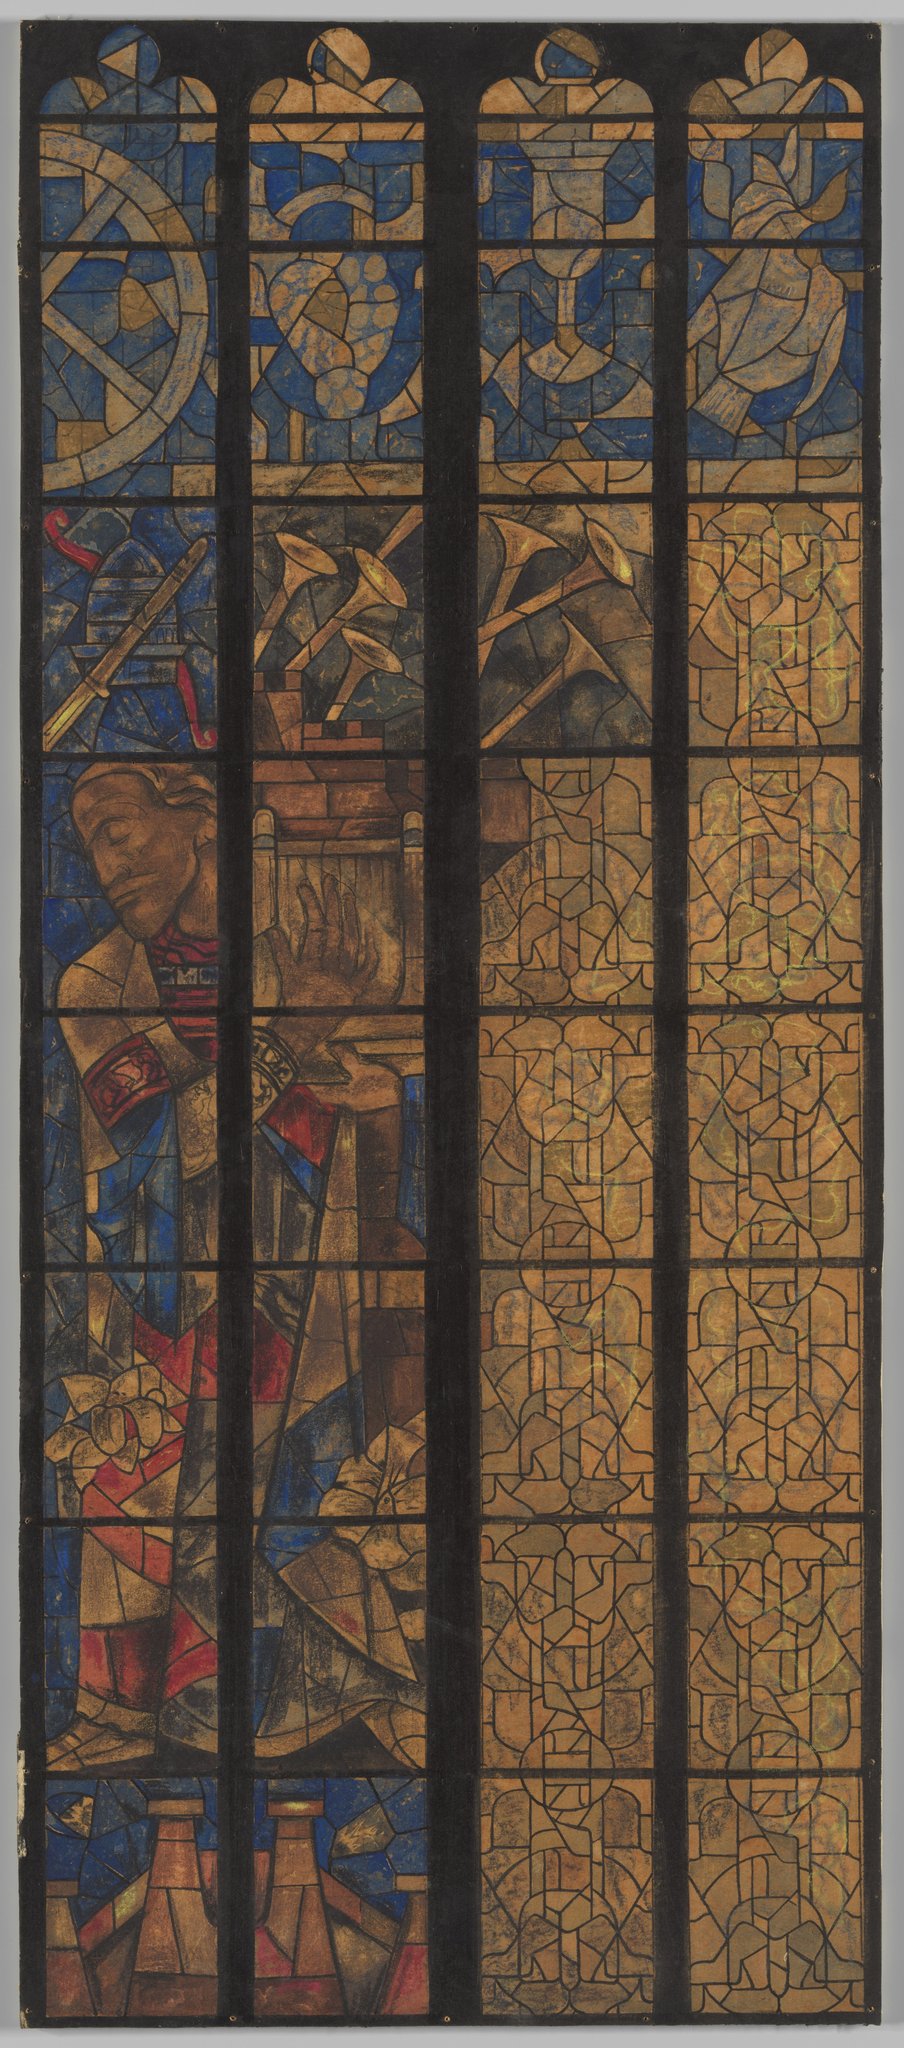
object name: drawing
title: Ontwerp voor een raam in het Noordertransept in de Dom te Utrecht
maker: richard nicolaüs roland holst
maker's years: 1868-1938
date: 1878-1938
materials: cardboard, chalk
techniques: brush